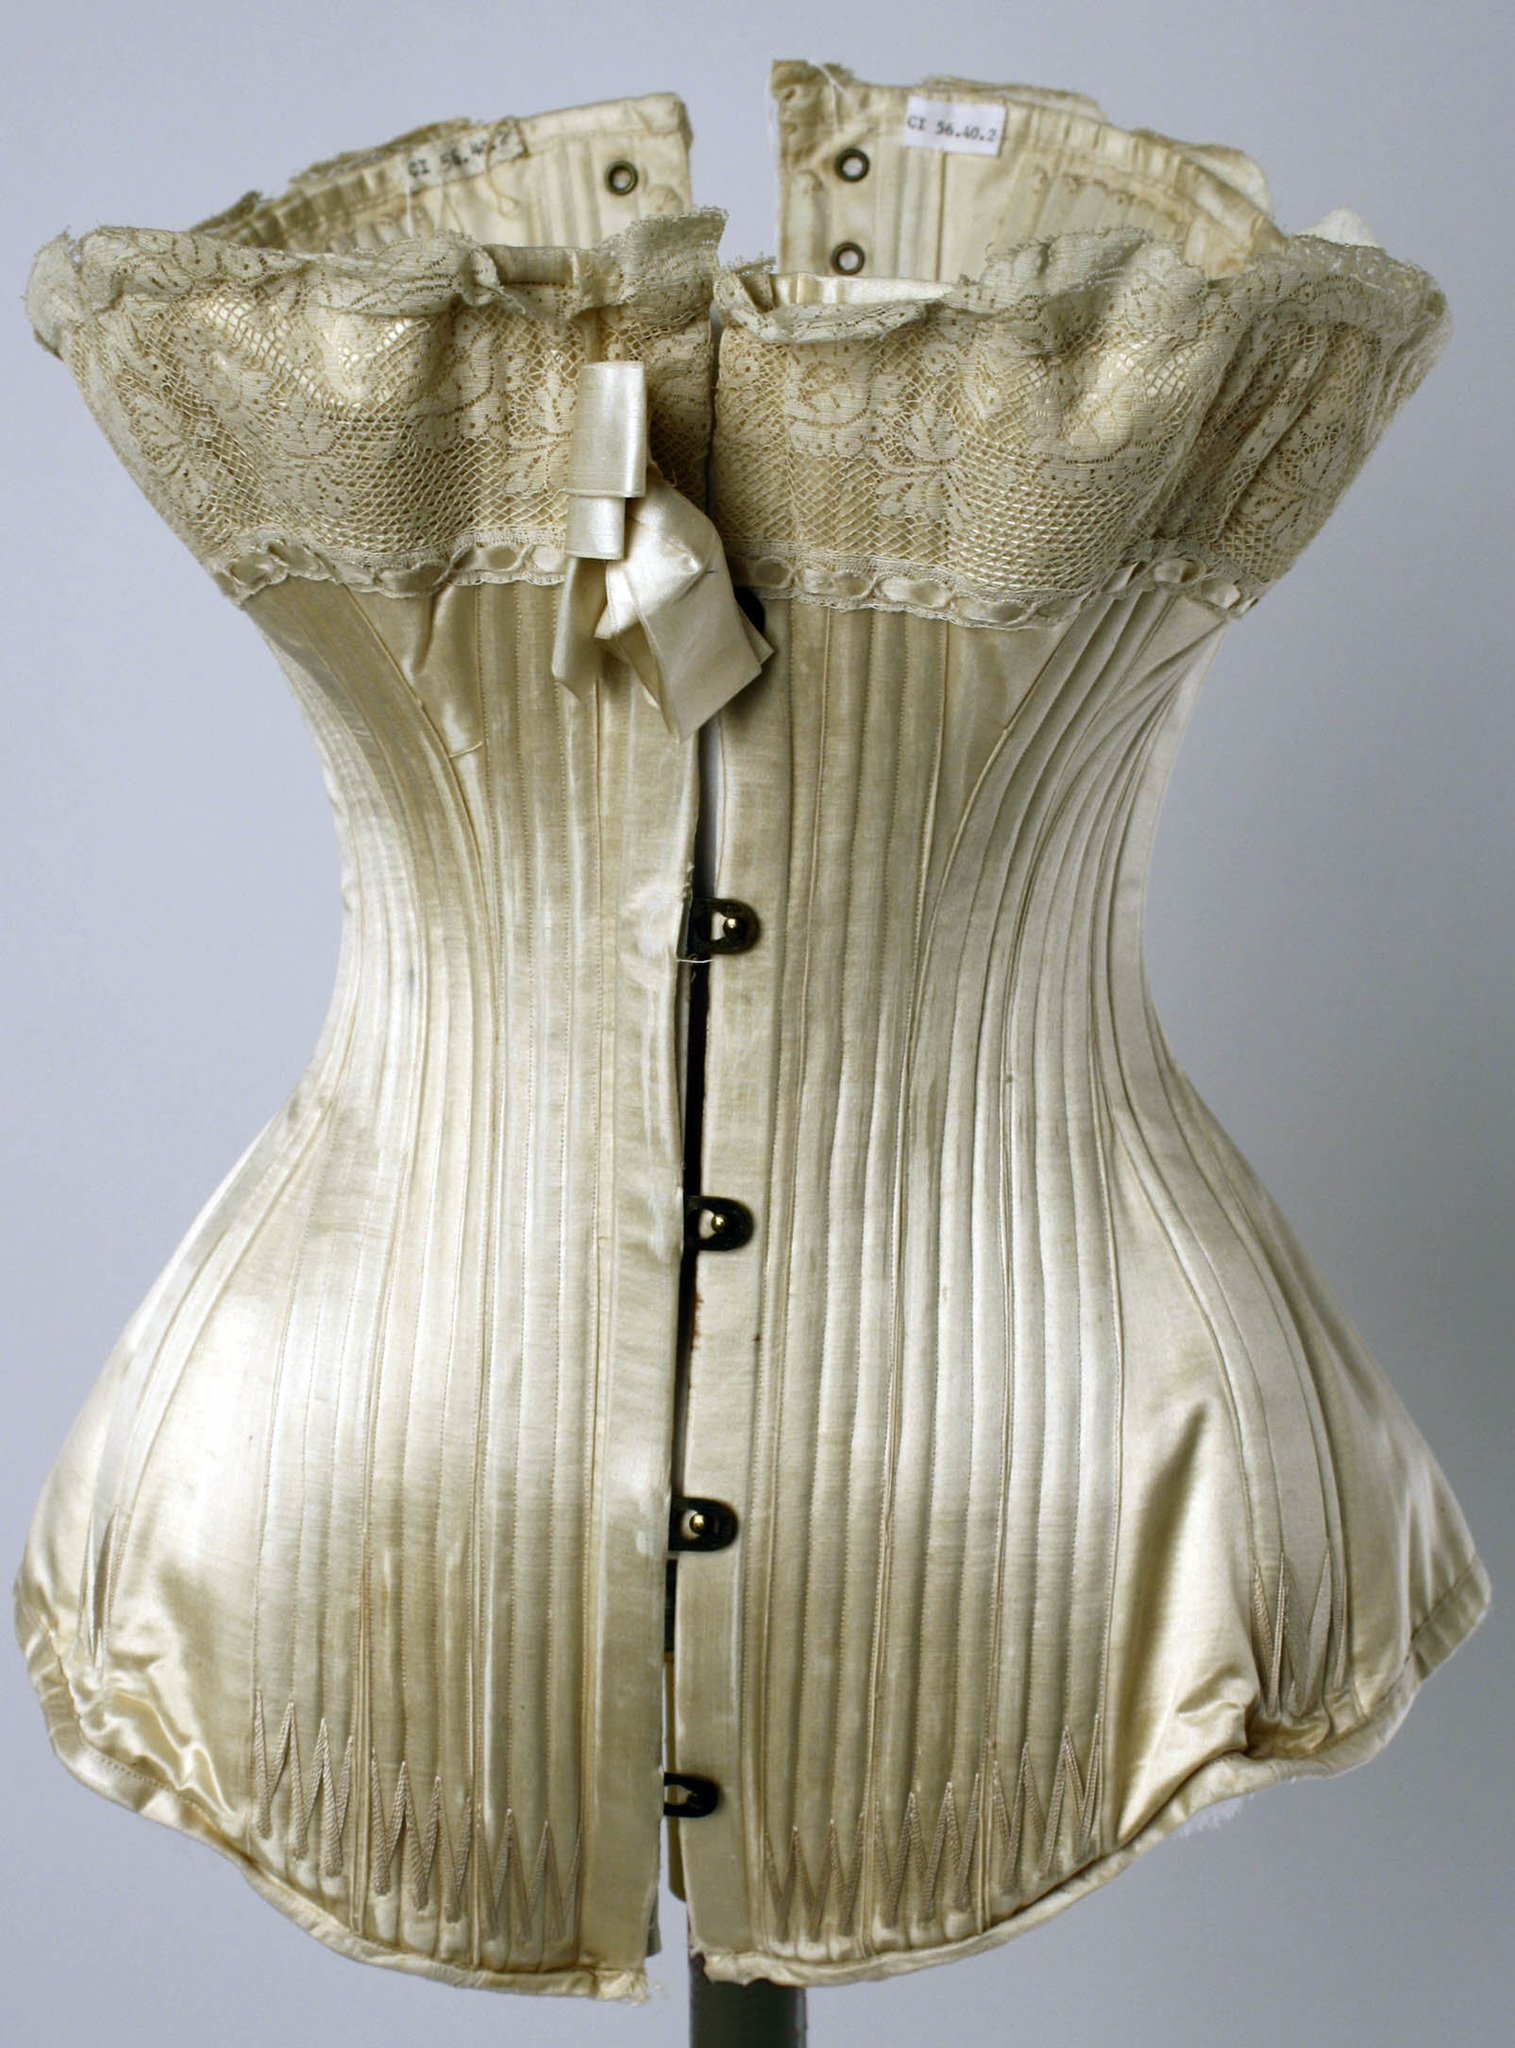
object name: corset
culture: french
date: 1884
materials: cotton, metal, silk